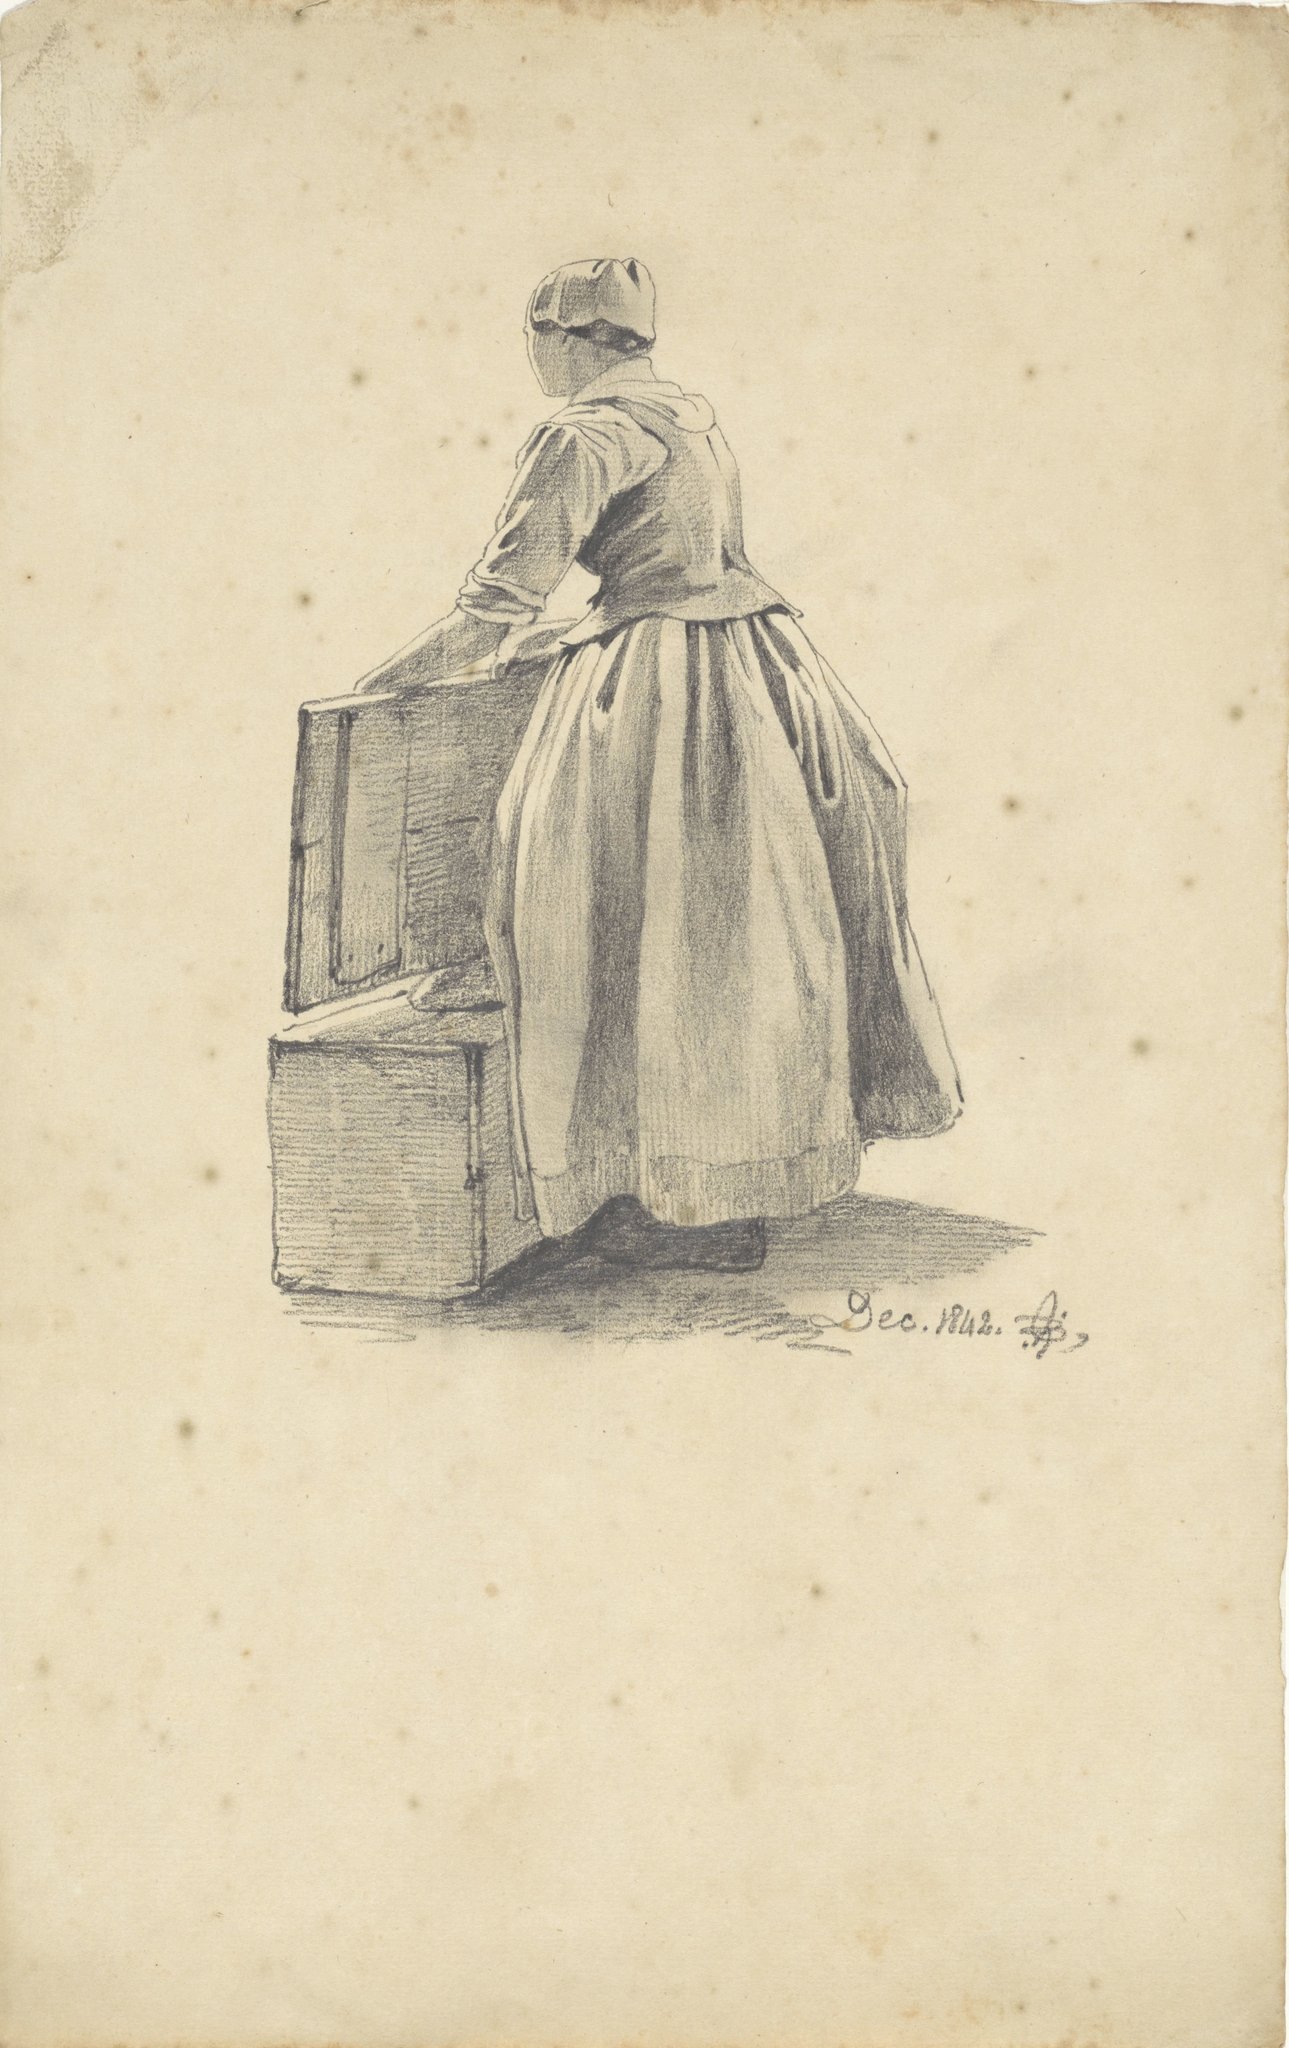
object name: drawing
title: Staande vrouw bij kist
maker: pieter van loon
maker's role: draughtsman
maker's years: 1801-1873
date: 1812-1842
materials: paper, pencil